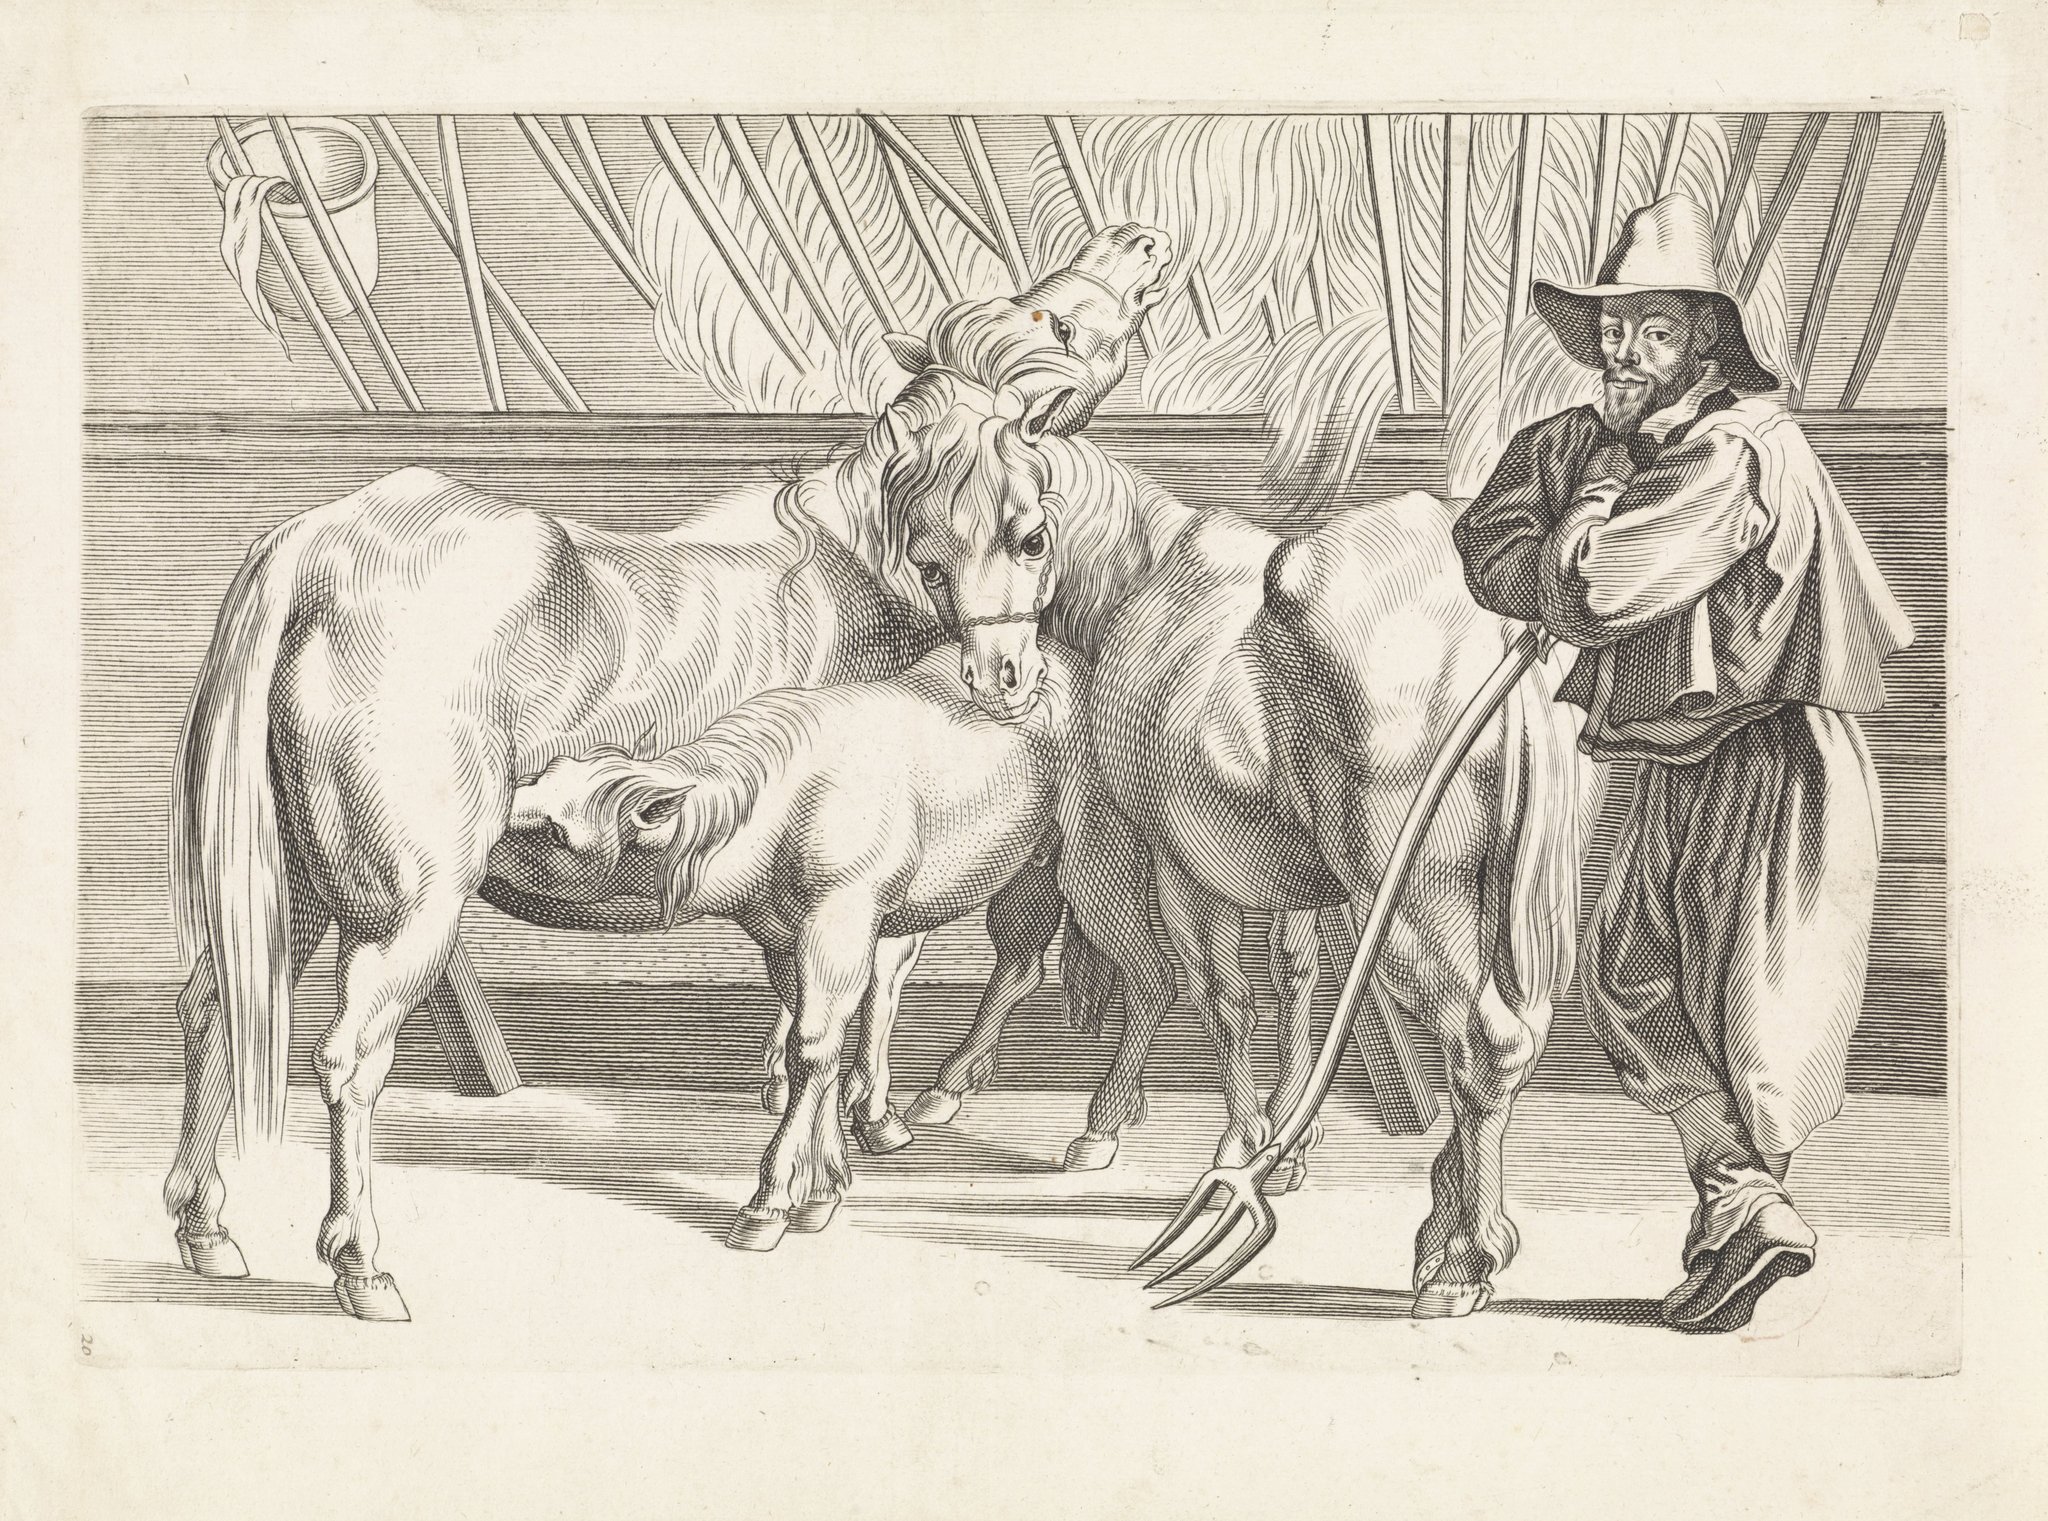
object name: print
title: Stal met paarden en stalmeester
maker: paulus pontius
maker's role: draughtsman, print maker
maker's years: 1603-1658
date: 1616-1657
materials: paper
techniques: engraving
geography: antwerp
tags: agricultural implements: pitchfork, horse, stall, stable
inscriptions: number: ‘20’, collector's mark: Lugt 240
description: Twee paarden en een veulen staan bij een ruif in de stal. De stalmeester leunt op zijn hooivork.